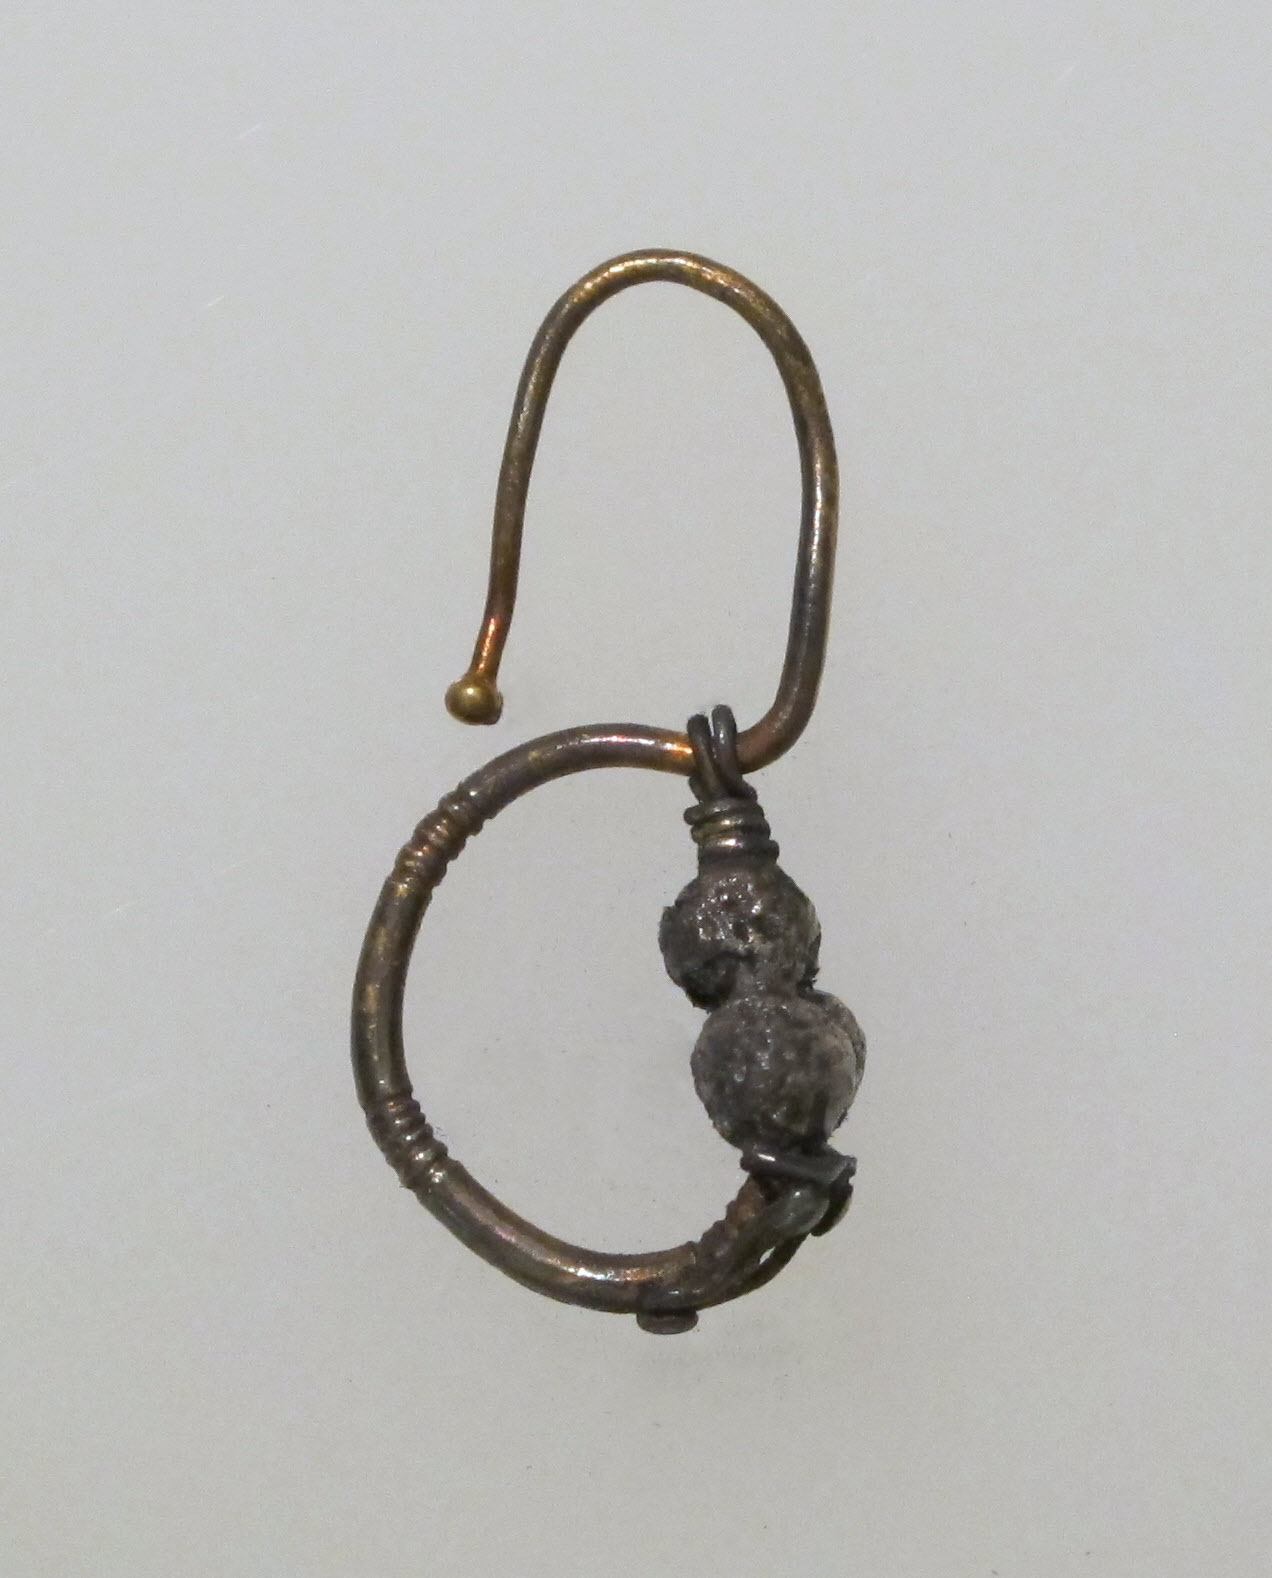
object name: earring, delta shaped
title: Earring, delta-shaped with beads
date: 7000 BCE-330 CE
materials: gold, silver